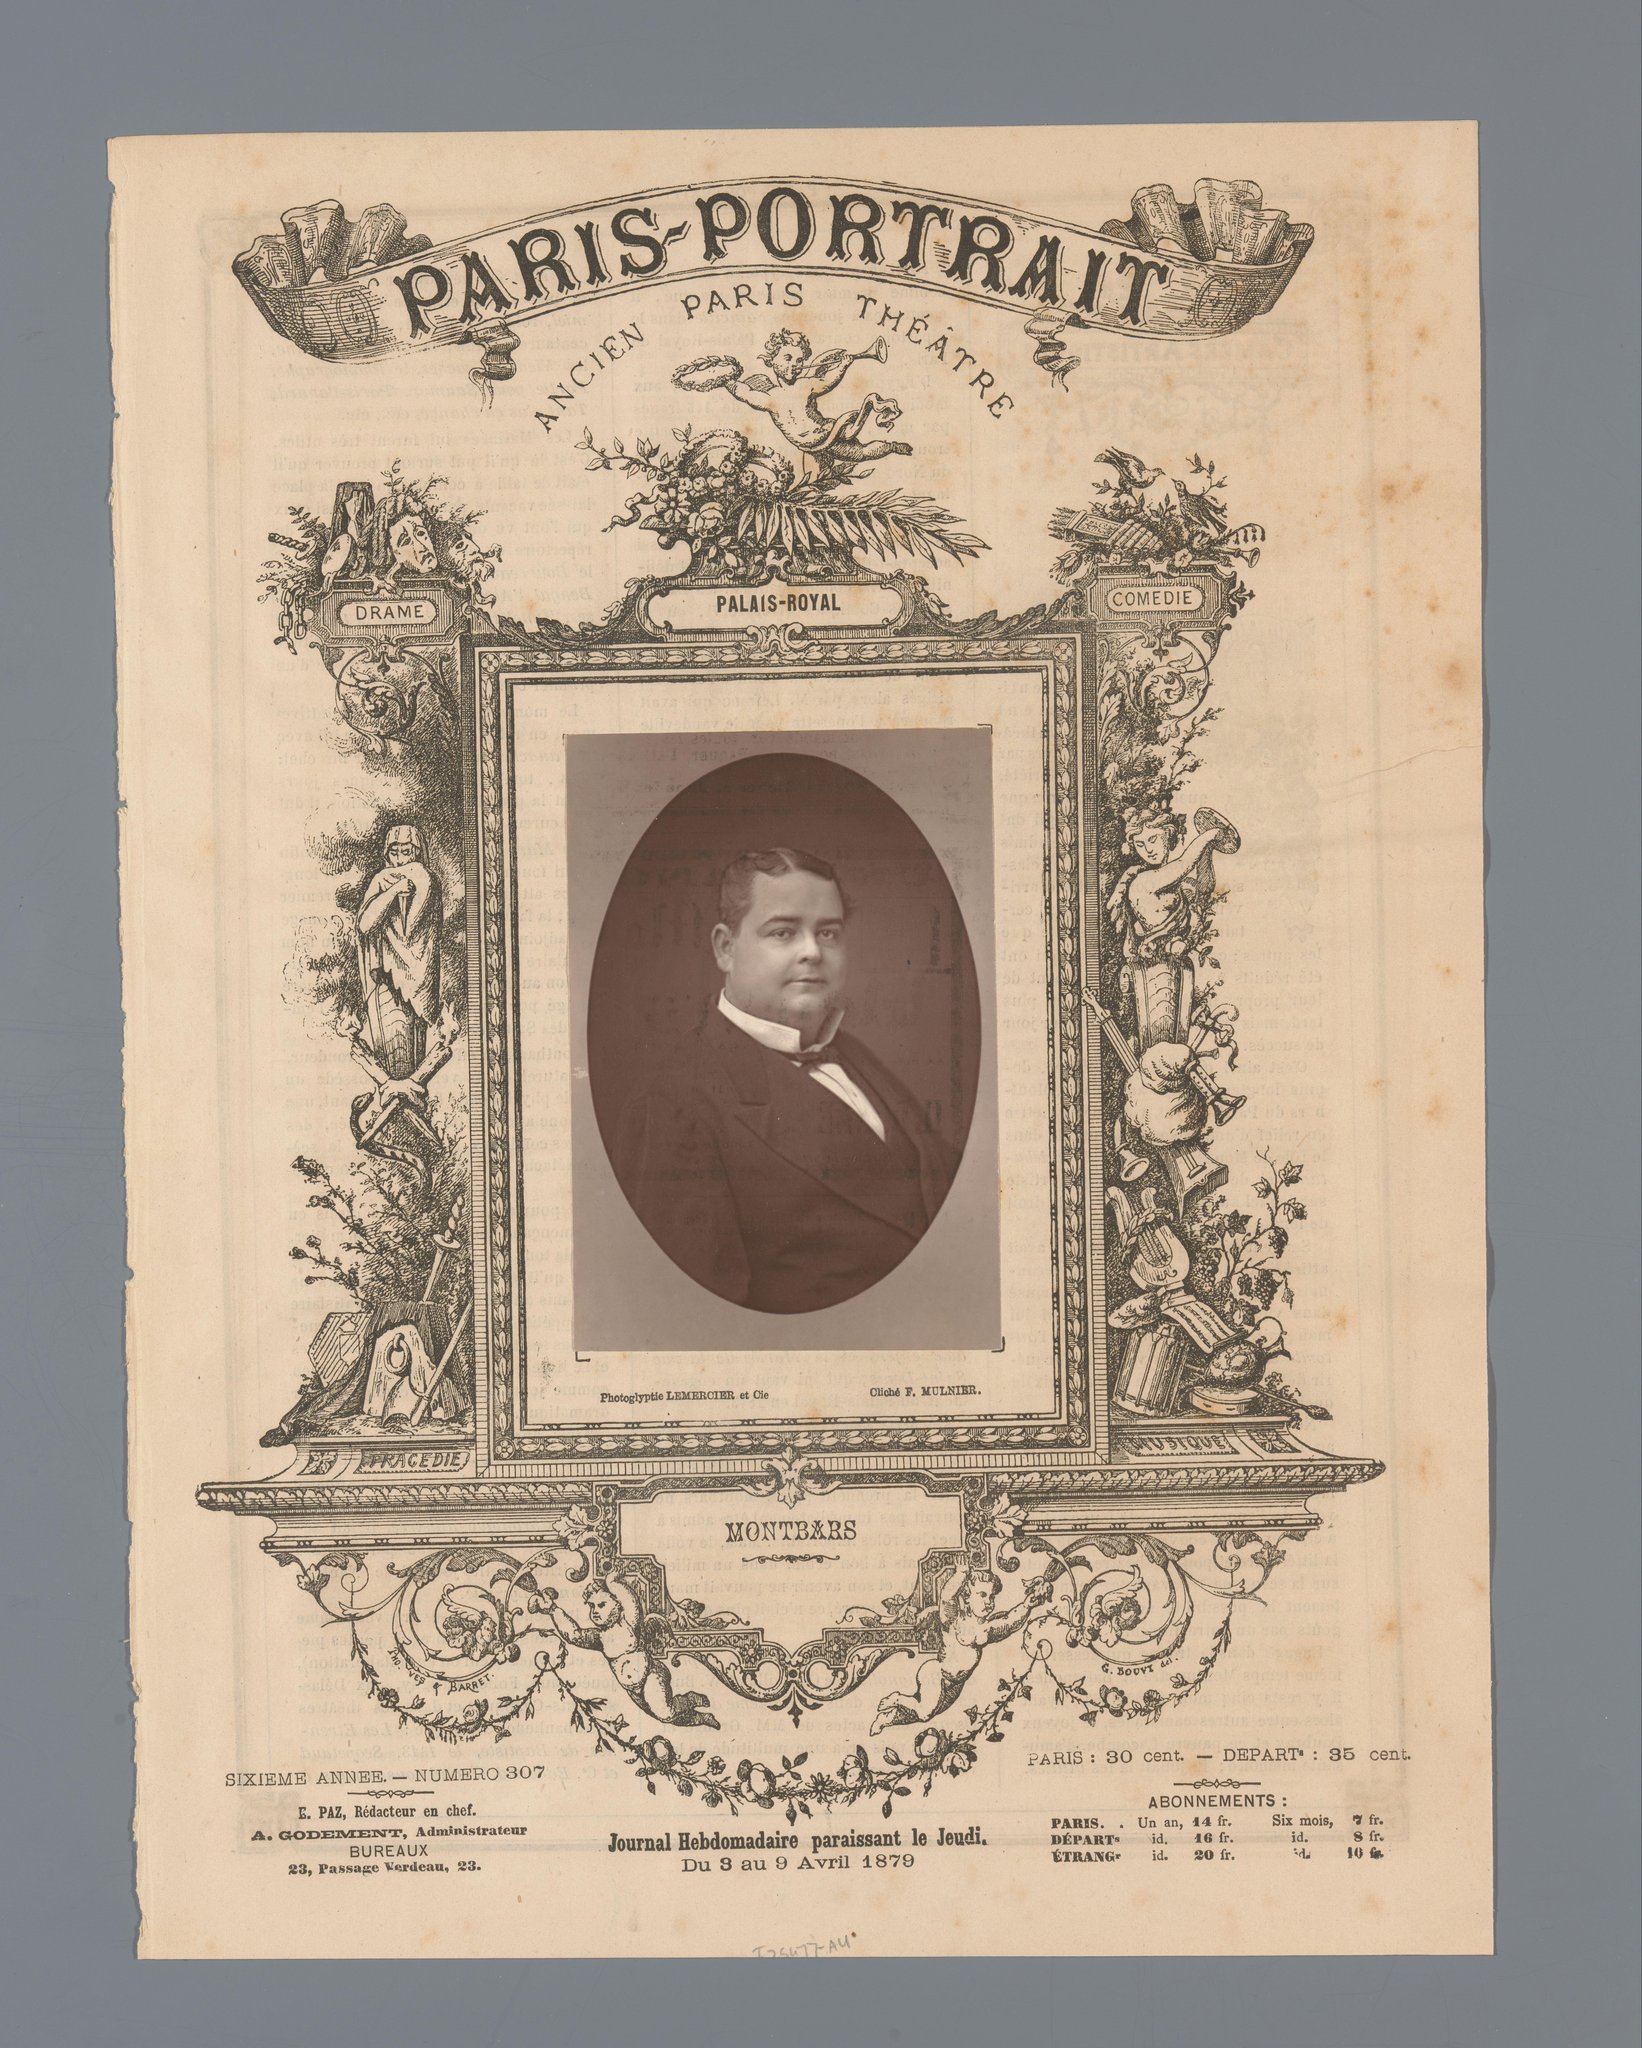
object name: photomechanical print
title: Montbars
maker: ferdinand mulnier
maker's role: painter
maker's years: 1817-1891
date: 1873-1880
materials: paper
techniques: woodburytype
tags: historical persons, portrait of actor, actress